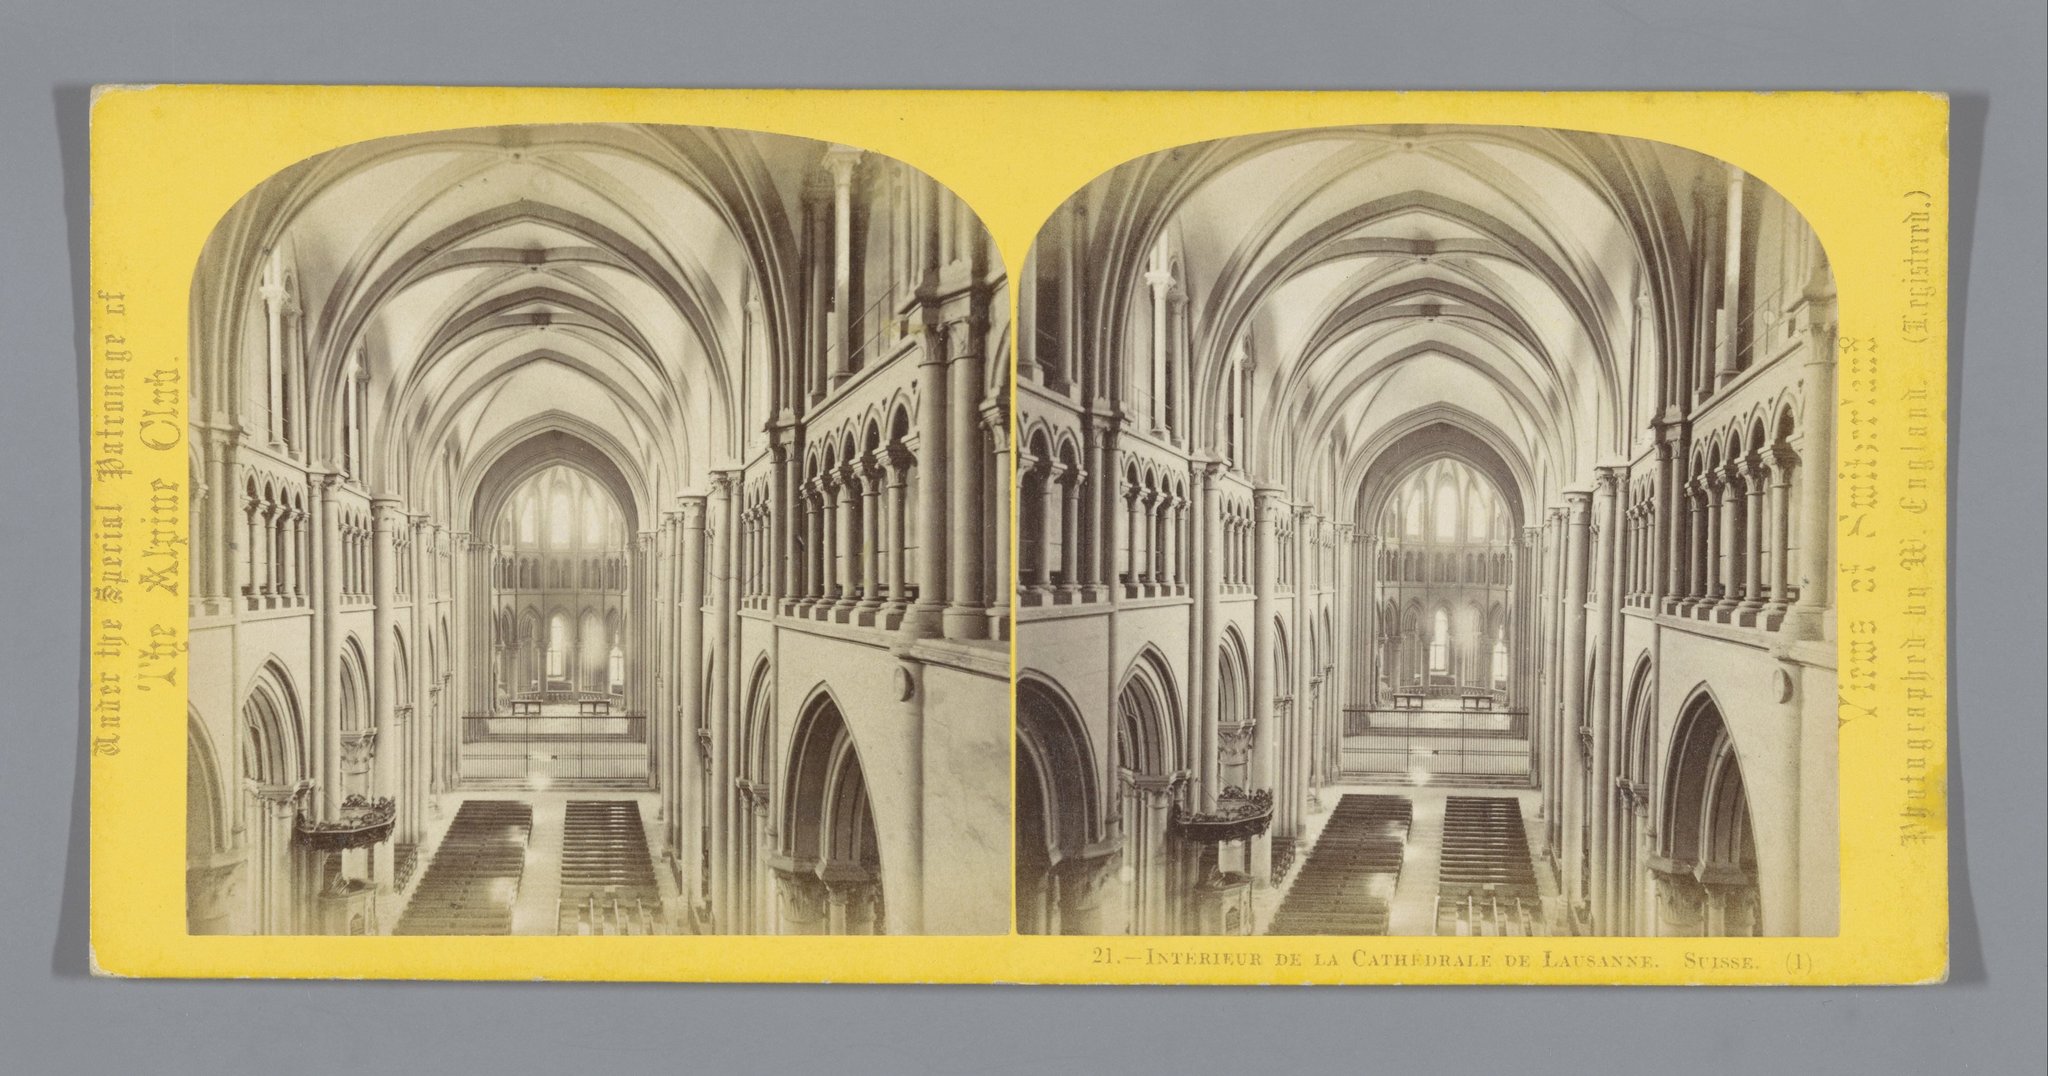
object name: stereograph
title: Intérieur de la Cathedrale de Lausanne. Suisse. (1)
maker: william england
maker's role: fotograaf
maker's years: 1816-1896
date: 1850-1880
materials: cardboard, photographic support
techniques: albumen print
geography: lausanne cathedral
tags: parts of church interior: nave, parts of church interior: choir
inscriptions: number: ‘21.’, inscription: ‘Views of Switzerland, photographed by W. England. (Registered) Under the Special Patronage of the Alpine Club.’